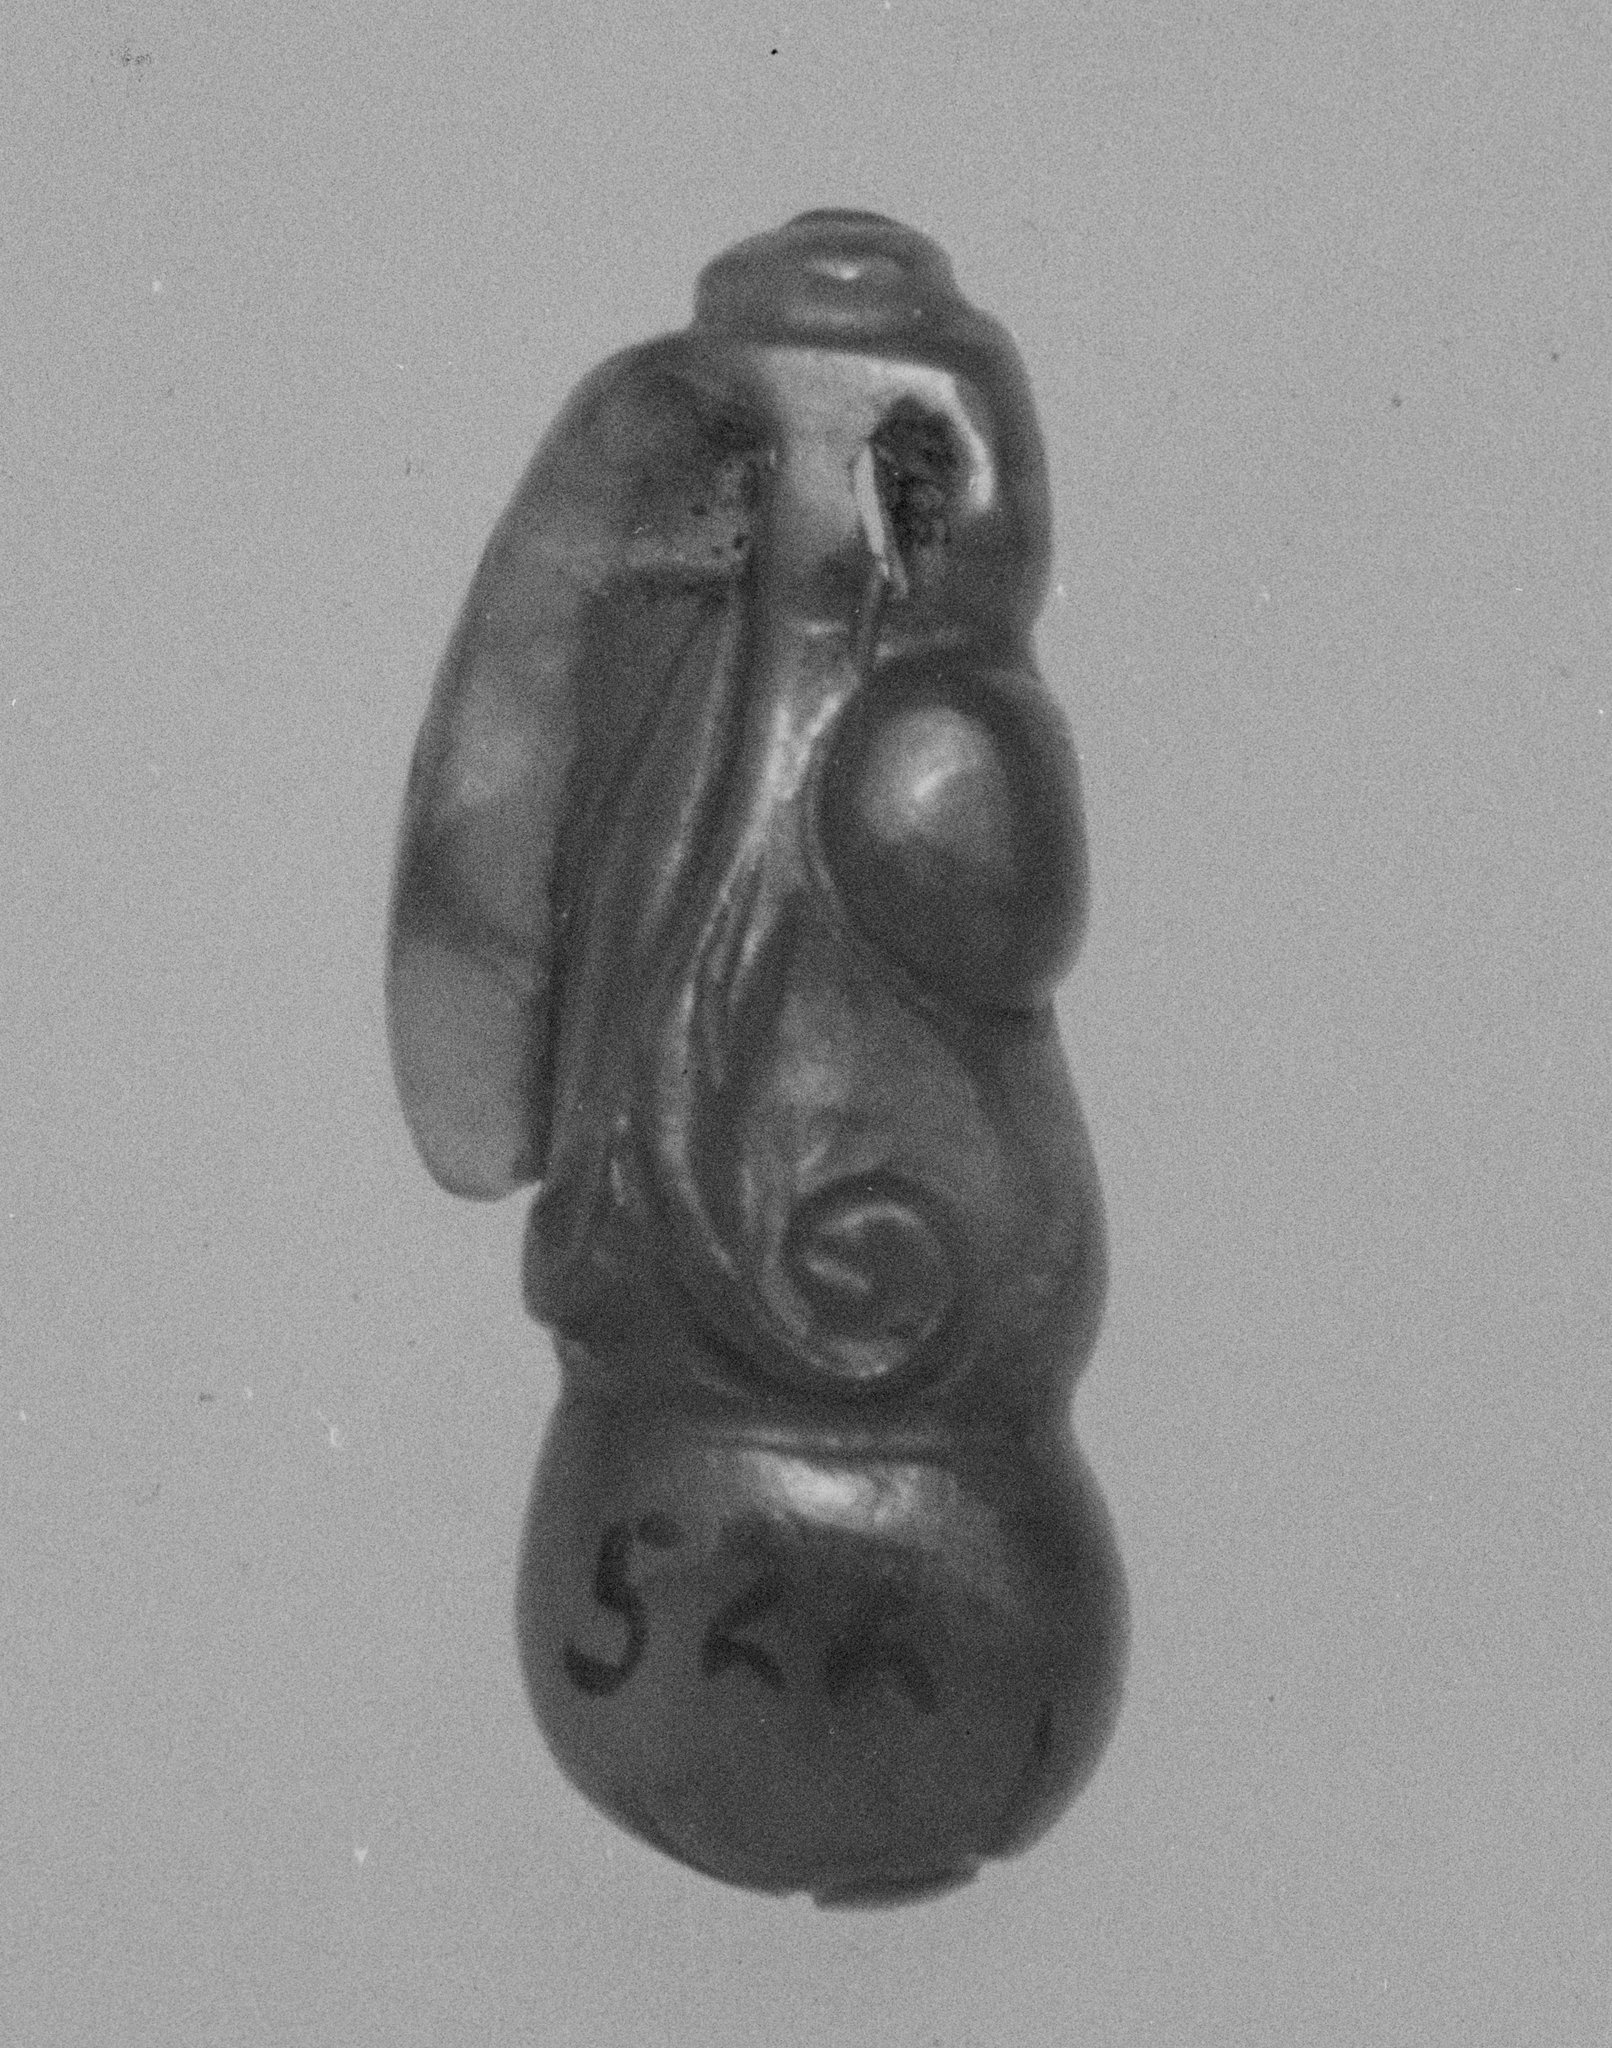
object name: pendant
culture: chinese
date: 1736-1795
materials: jade